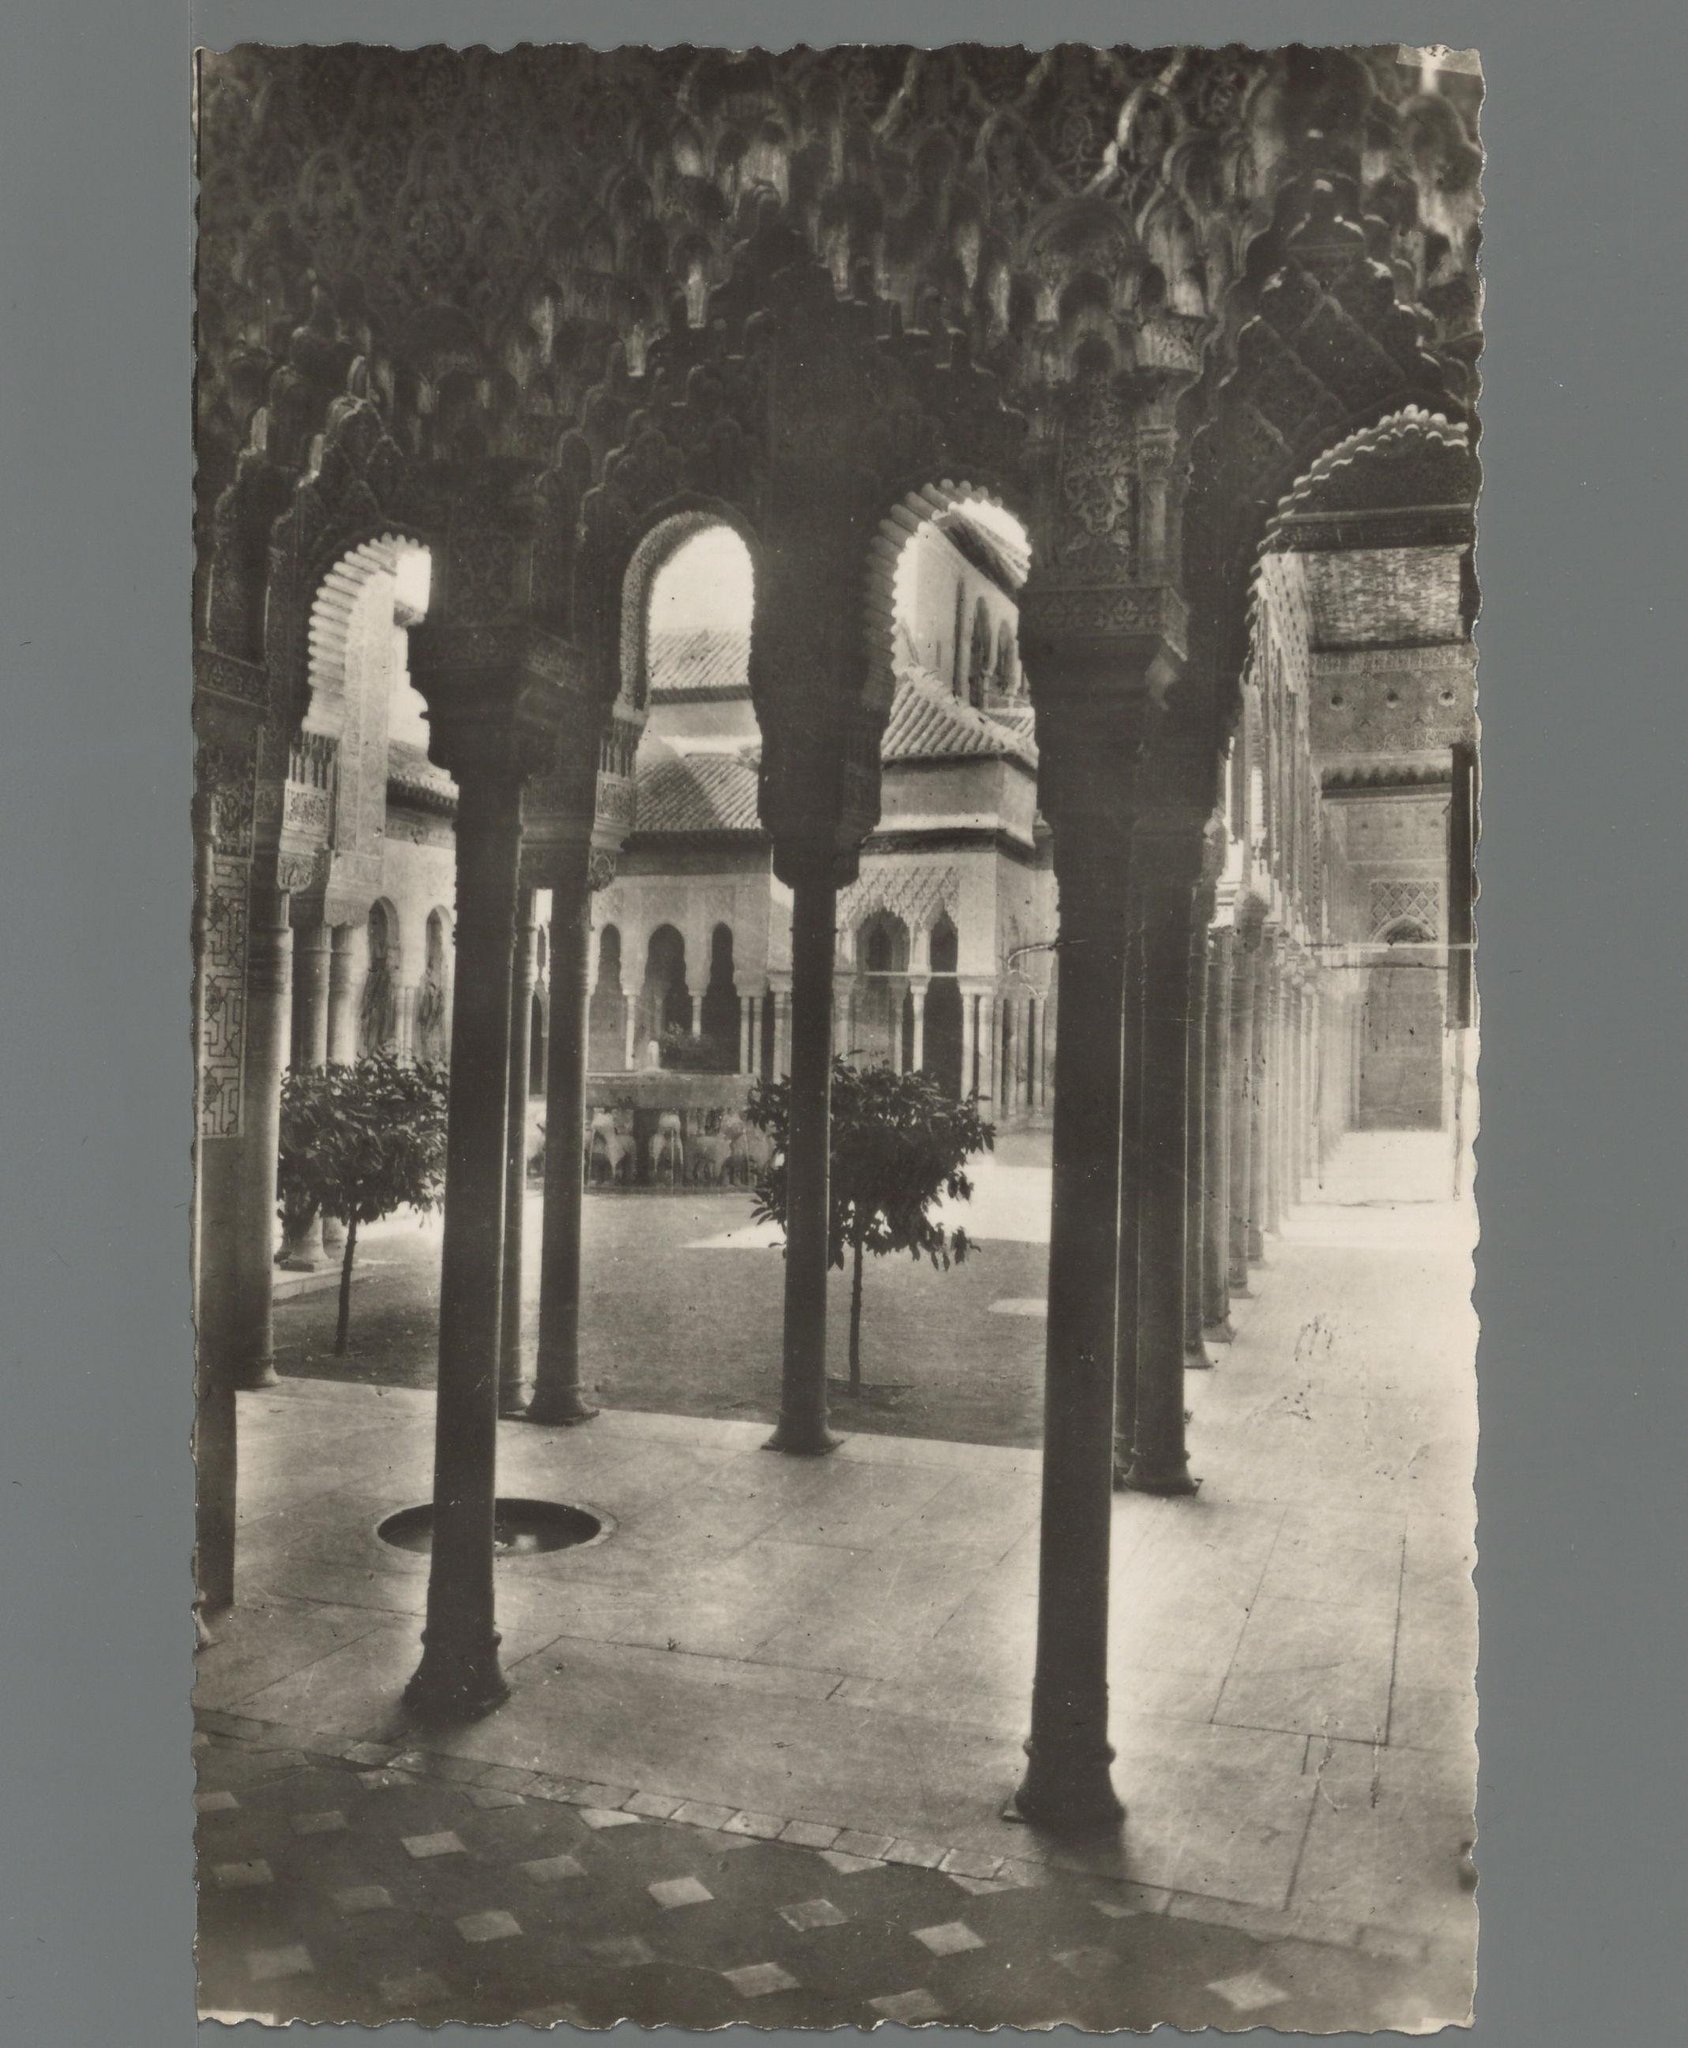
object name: ansichtkaart, prentbriefkaart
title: Granada - Alhambra: Patio de los Leones / Alhambra: Cour des Lions / Alhambra: Lions Courtyard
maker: Anonymous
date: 1918-1930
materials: paper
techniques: gelatin silver print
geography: granada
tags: palace, courtyard